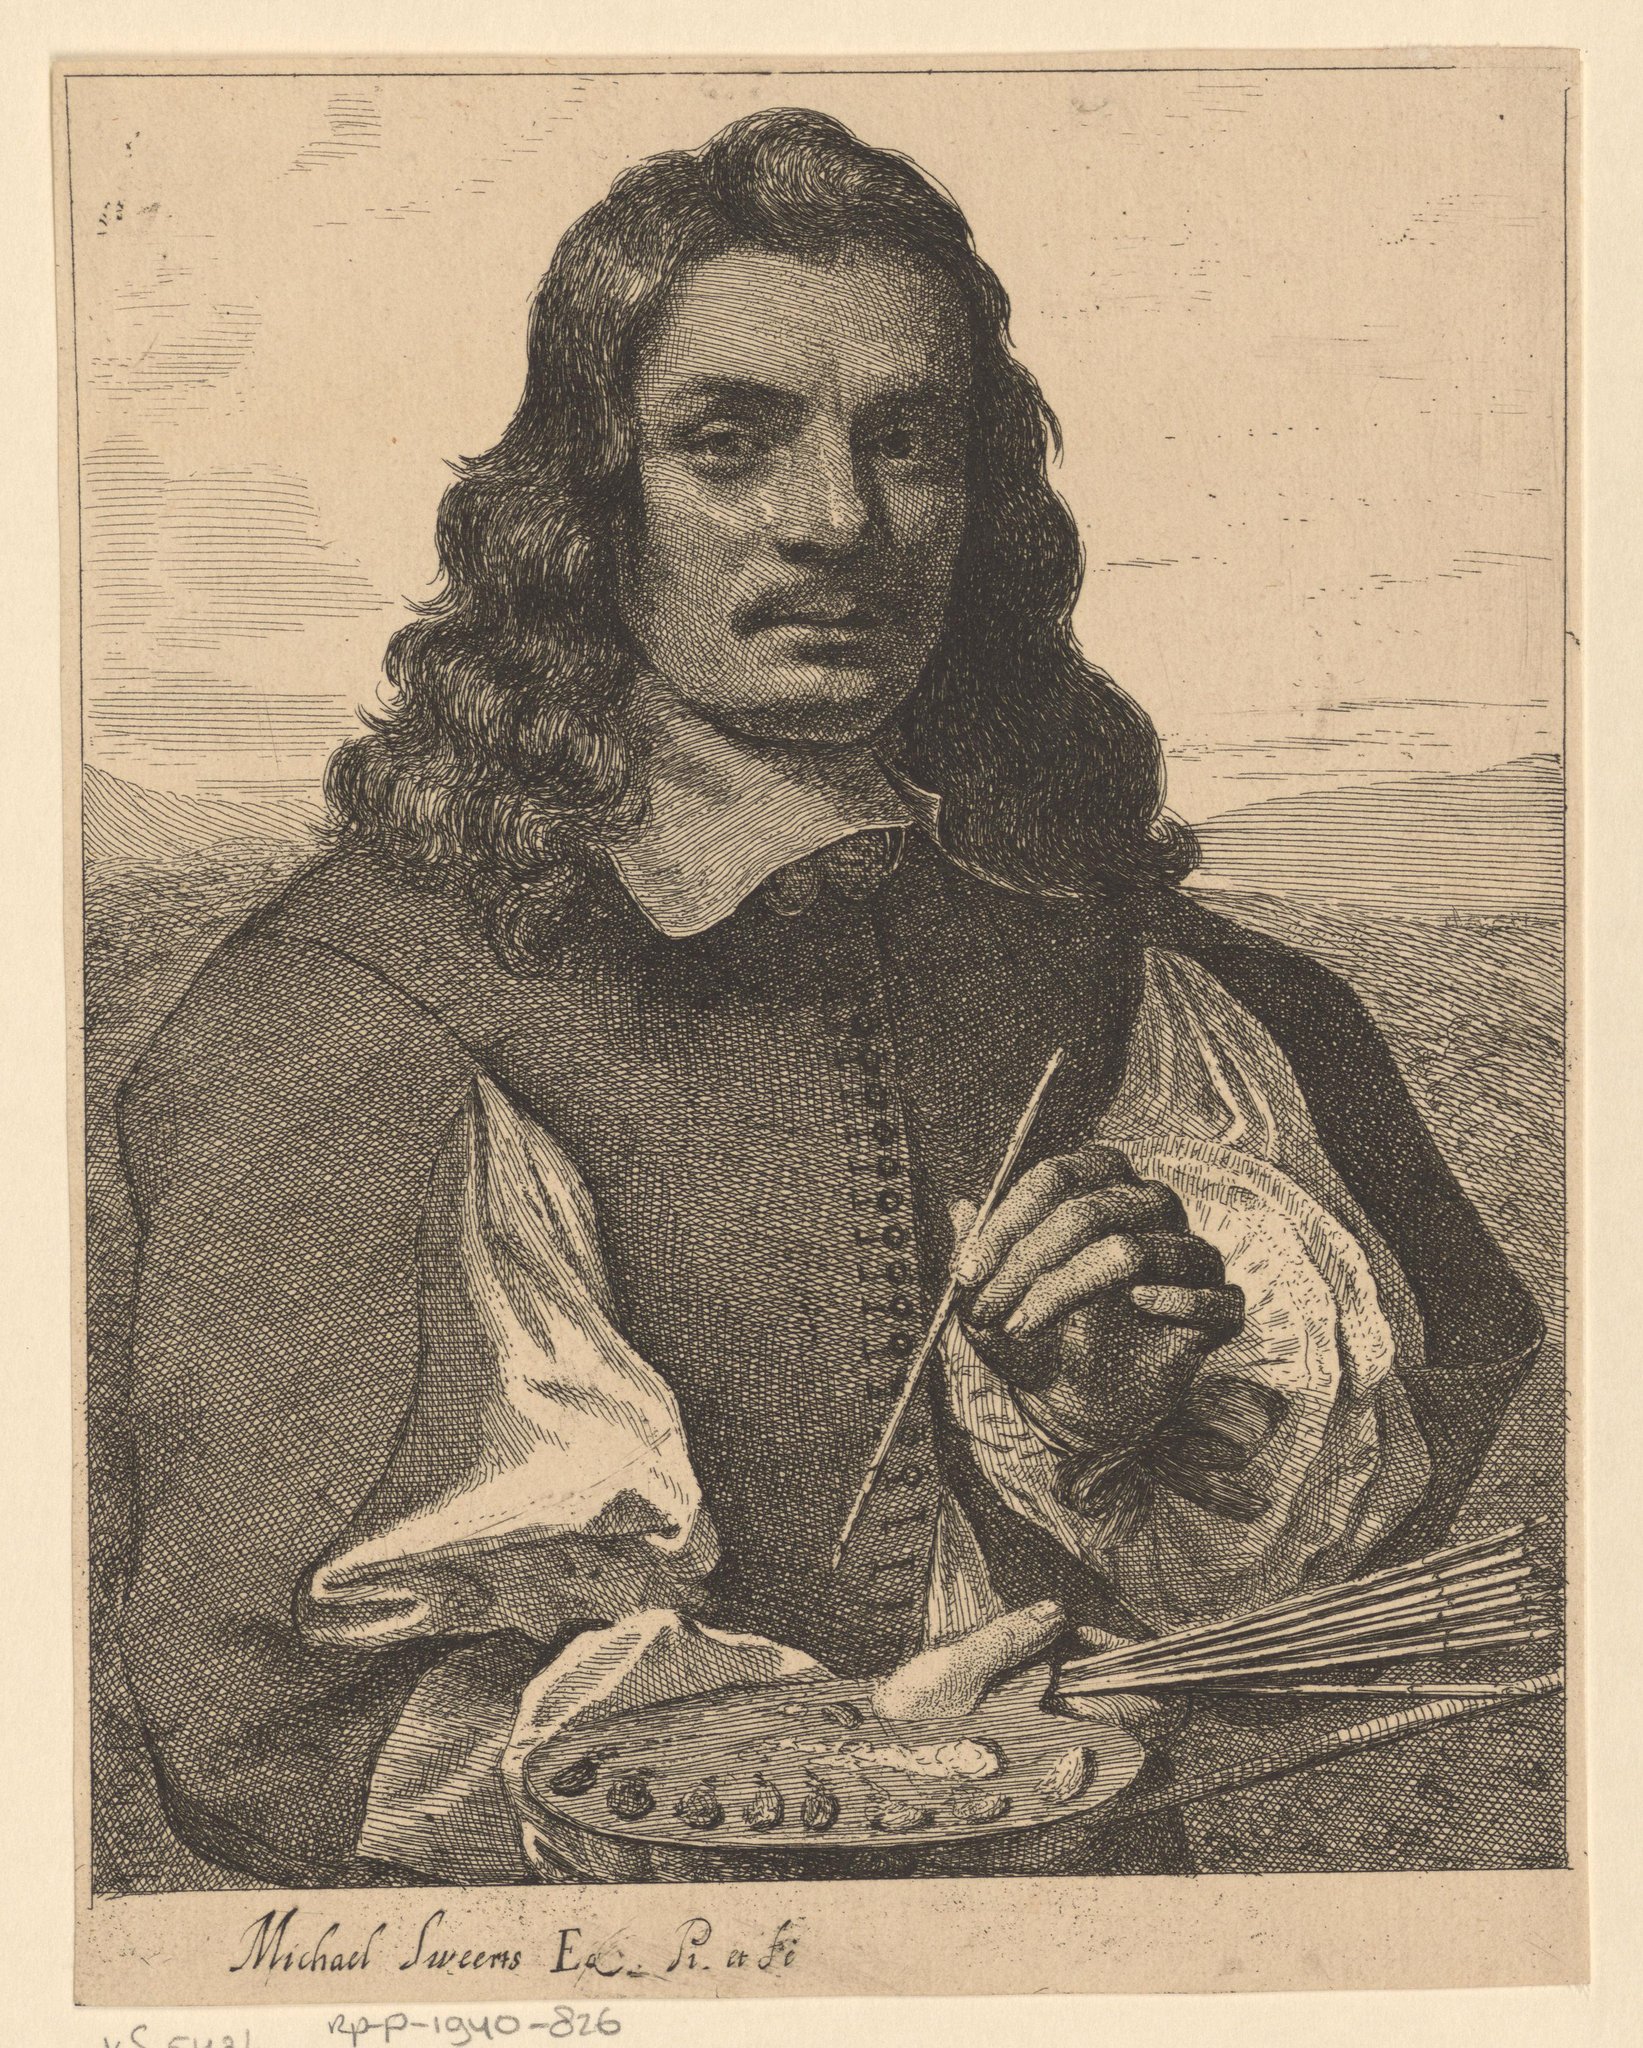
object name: print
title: Zelfportret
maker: michael sweerts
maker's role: painter, print maker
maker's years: 1618-1664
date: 1643-1661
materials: paper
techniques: etching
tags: painter, print maker, michael sweerts, historical persons, portrait, self-portrait of painter, portrait, self-portrait of graphic artist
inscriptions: collector's mark: Lugt 68, collector's mark: Lugt 2760, collector's mark: Lugt 2228